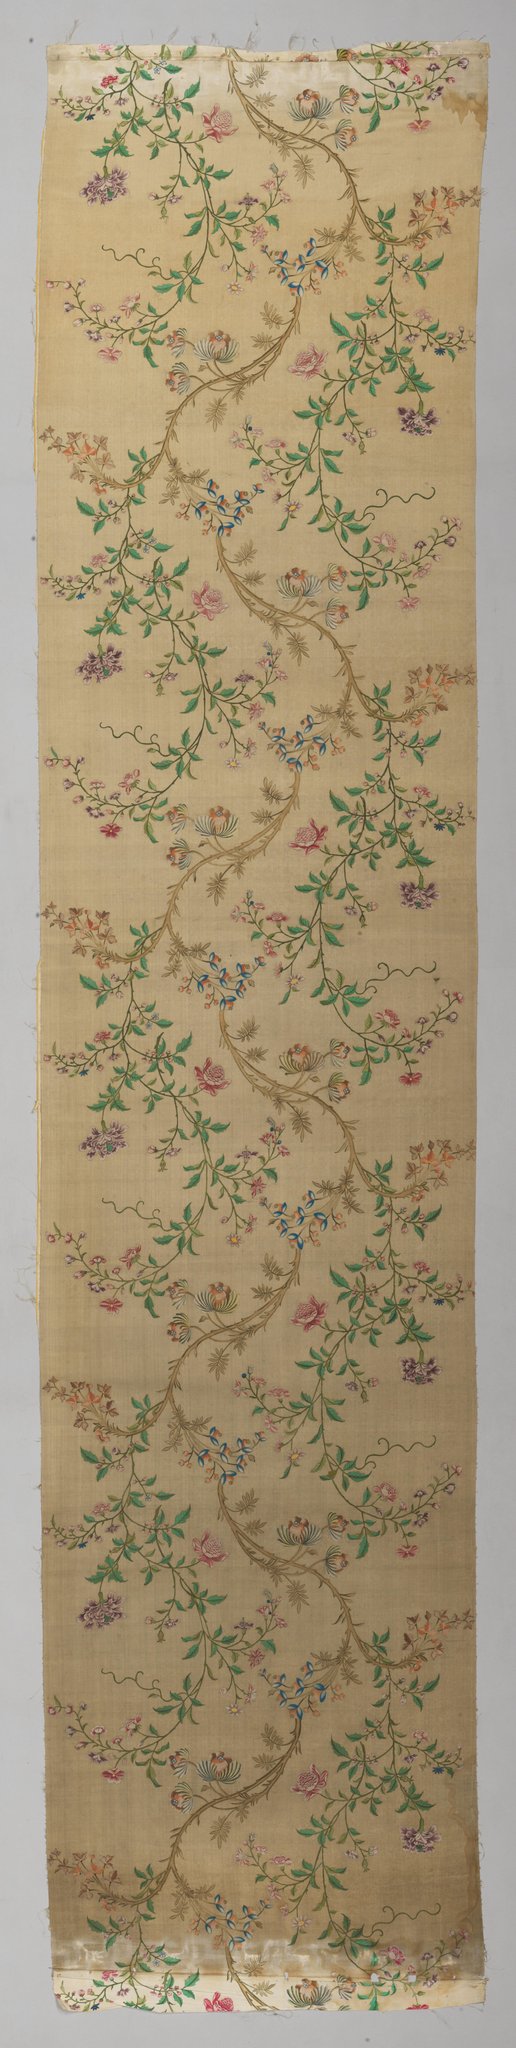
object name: upholstery fabric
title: Bespanningsstof met decor van takken, bladeren, bloemen en vruchten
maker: Anonymous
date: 1750-1790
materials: paint, silk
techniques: printing, weave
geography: china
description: Een baan veelkleurig beschilderde creme bespanningsstof van zijde. Beschrijving zie A.